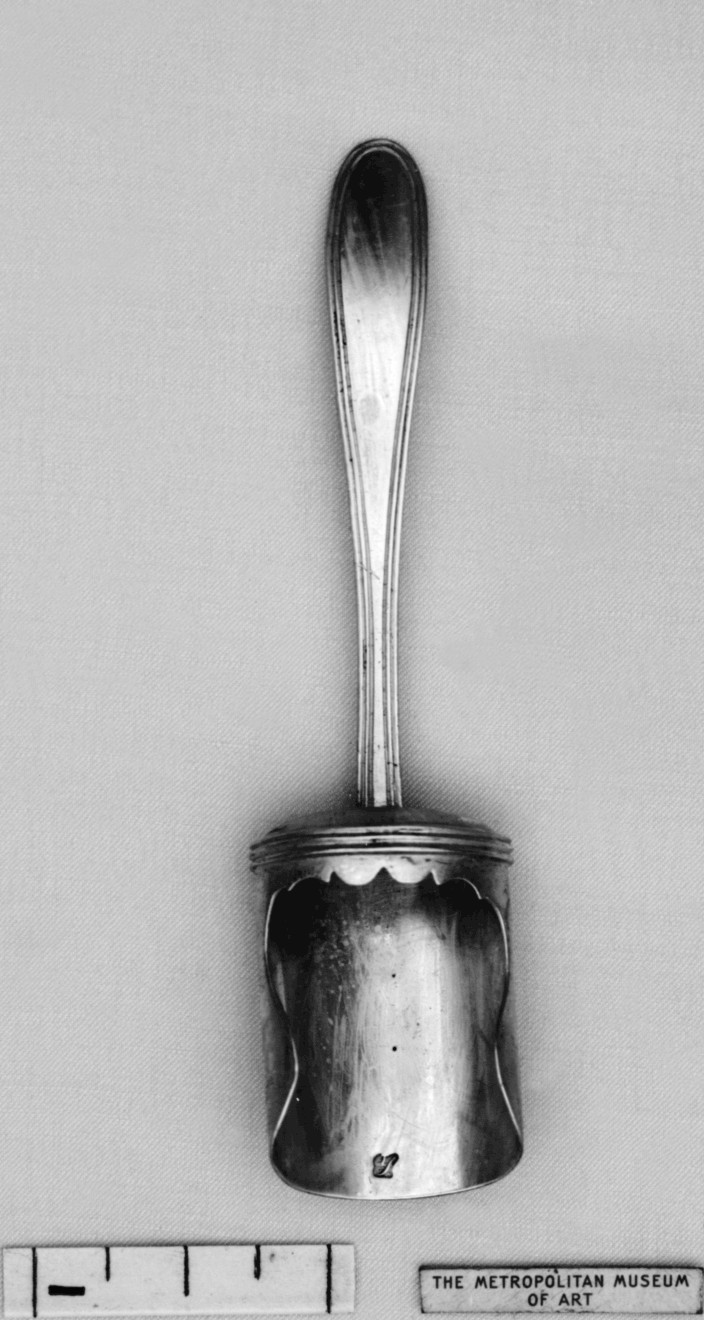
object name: caddy spoon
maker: christoffel oepkes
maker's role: maker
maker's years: 1812-1819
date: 1767-1833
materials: silver